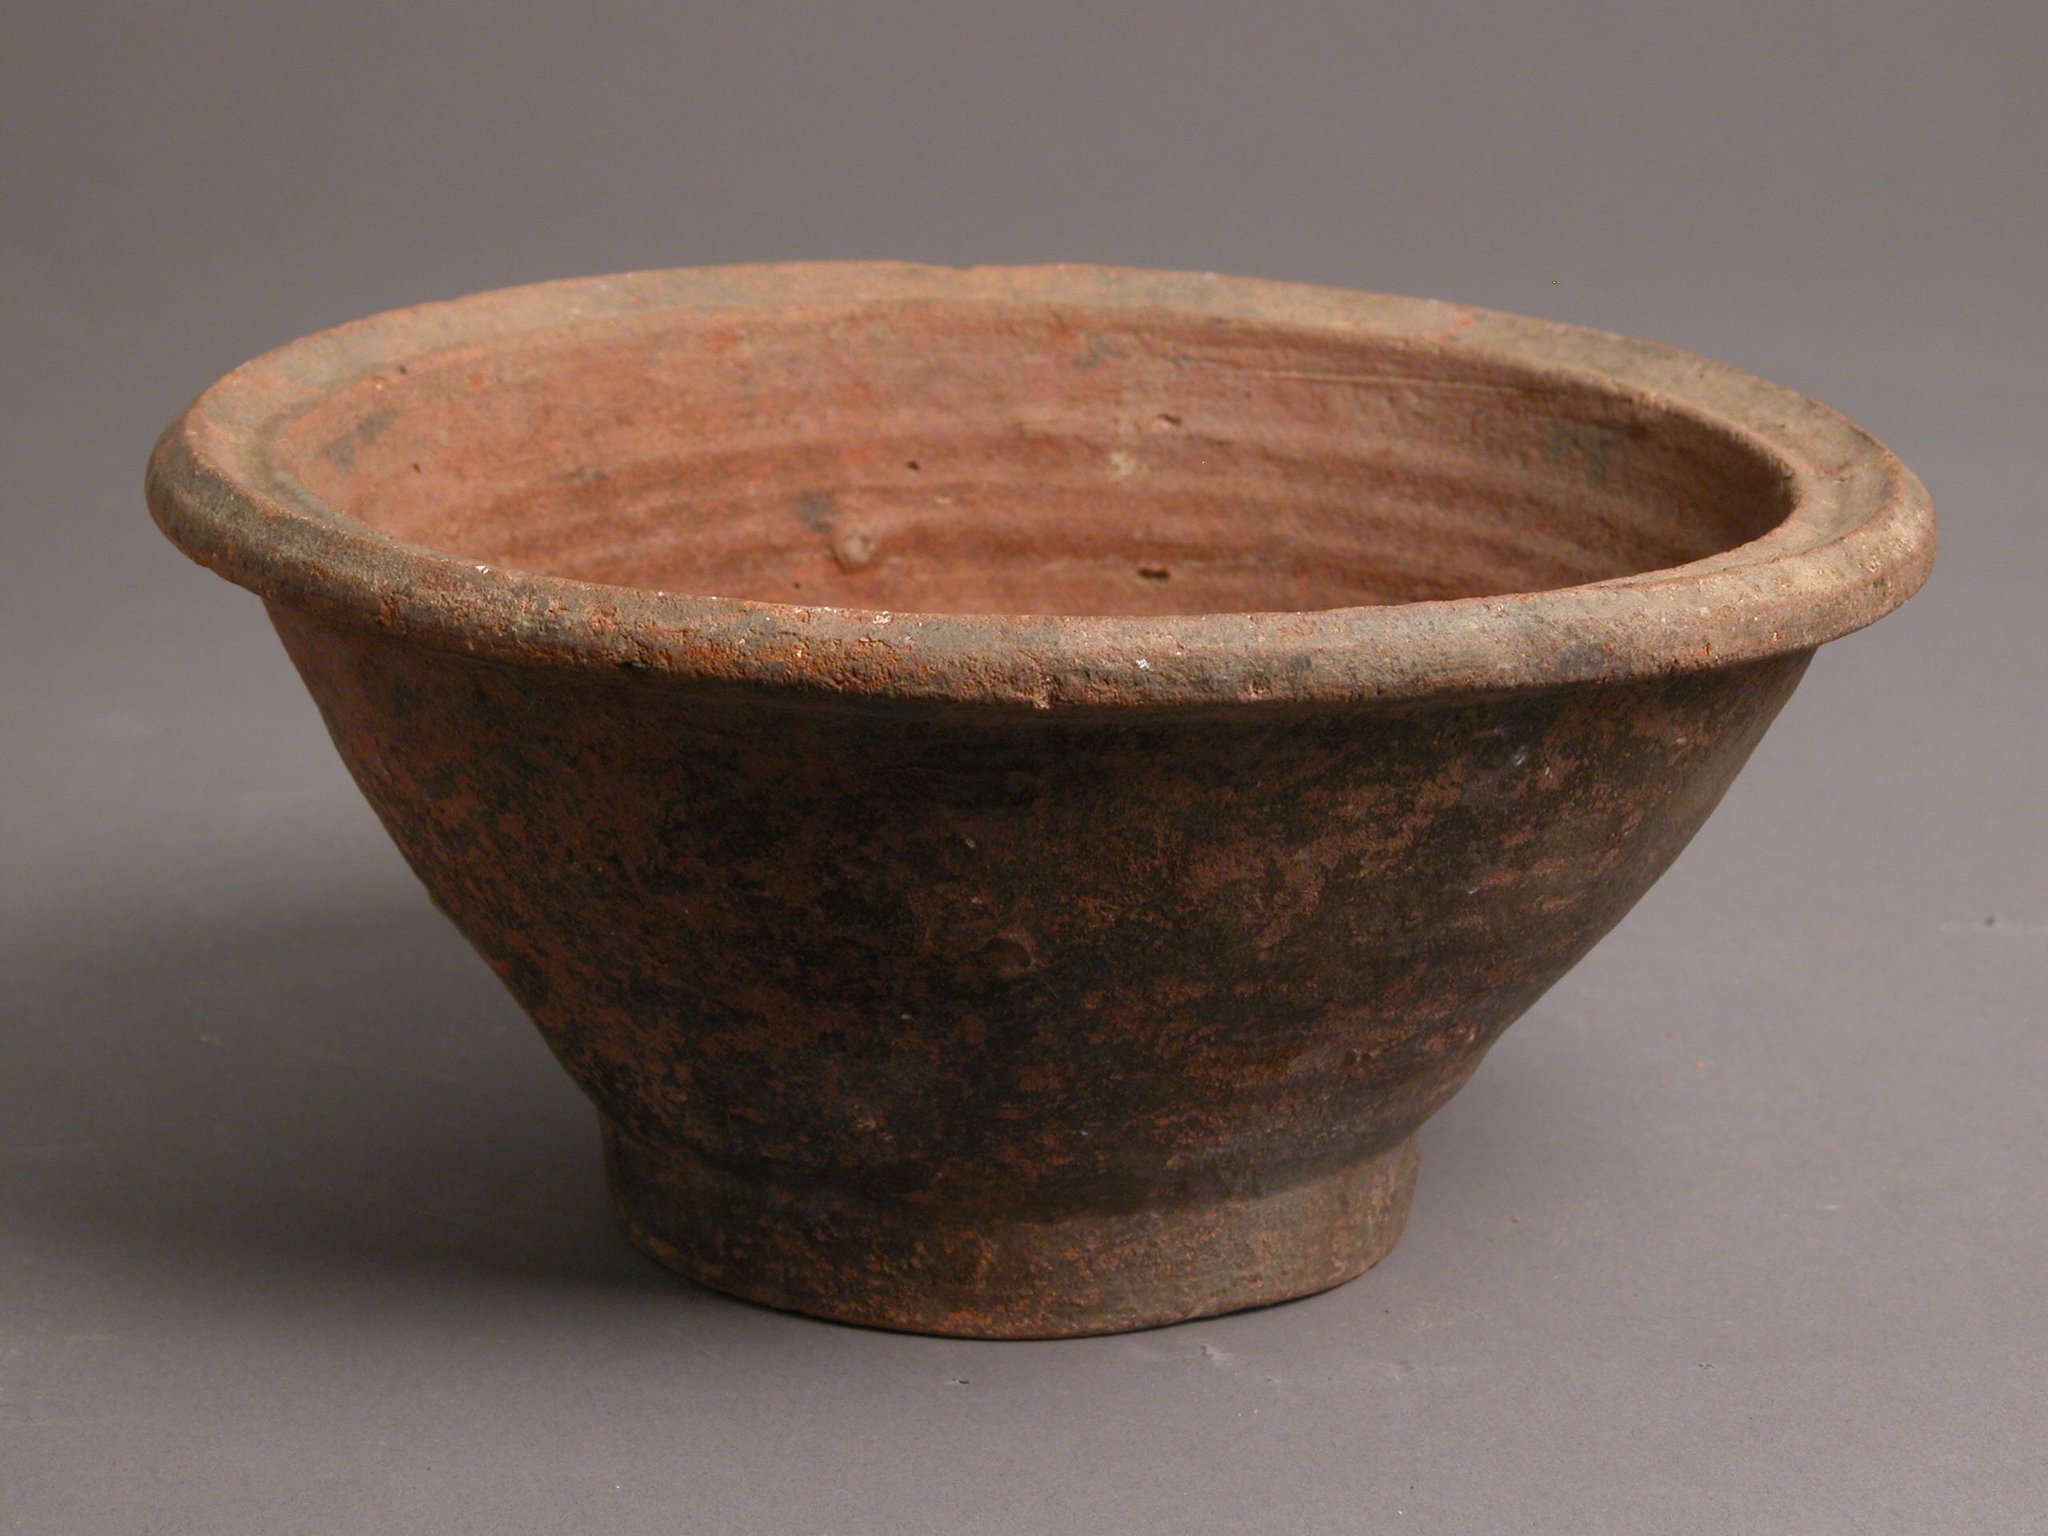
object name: bowl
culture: coptic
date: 301-700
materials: earthenware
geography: egypt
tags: bowls